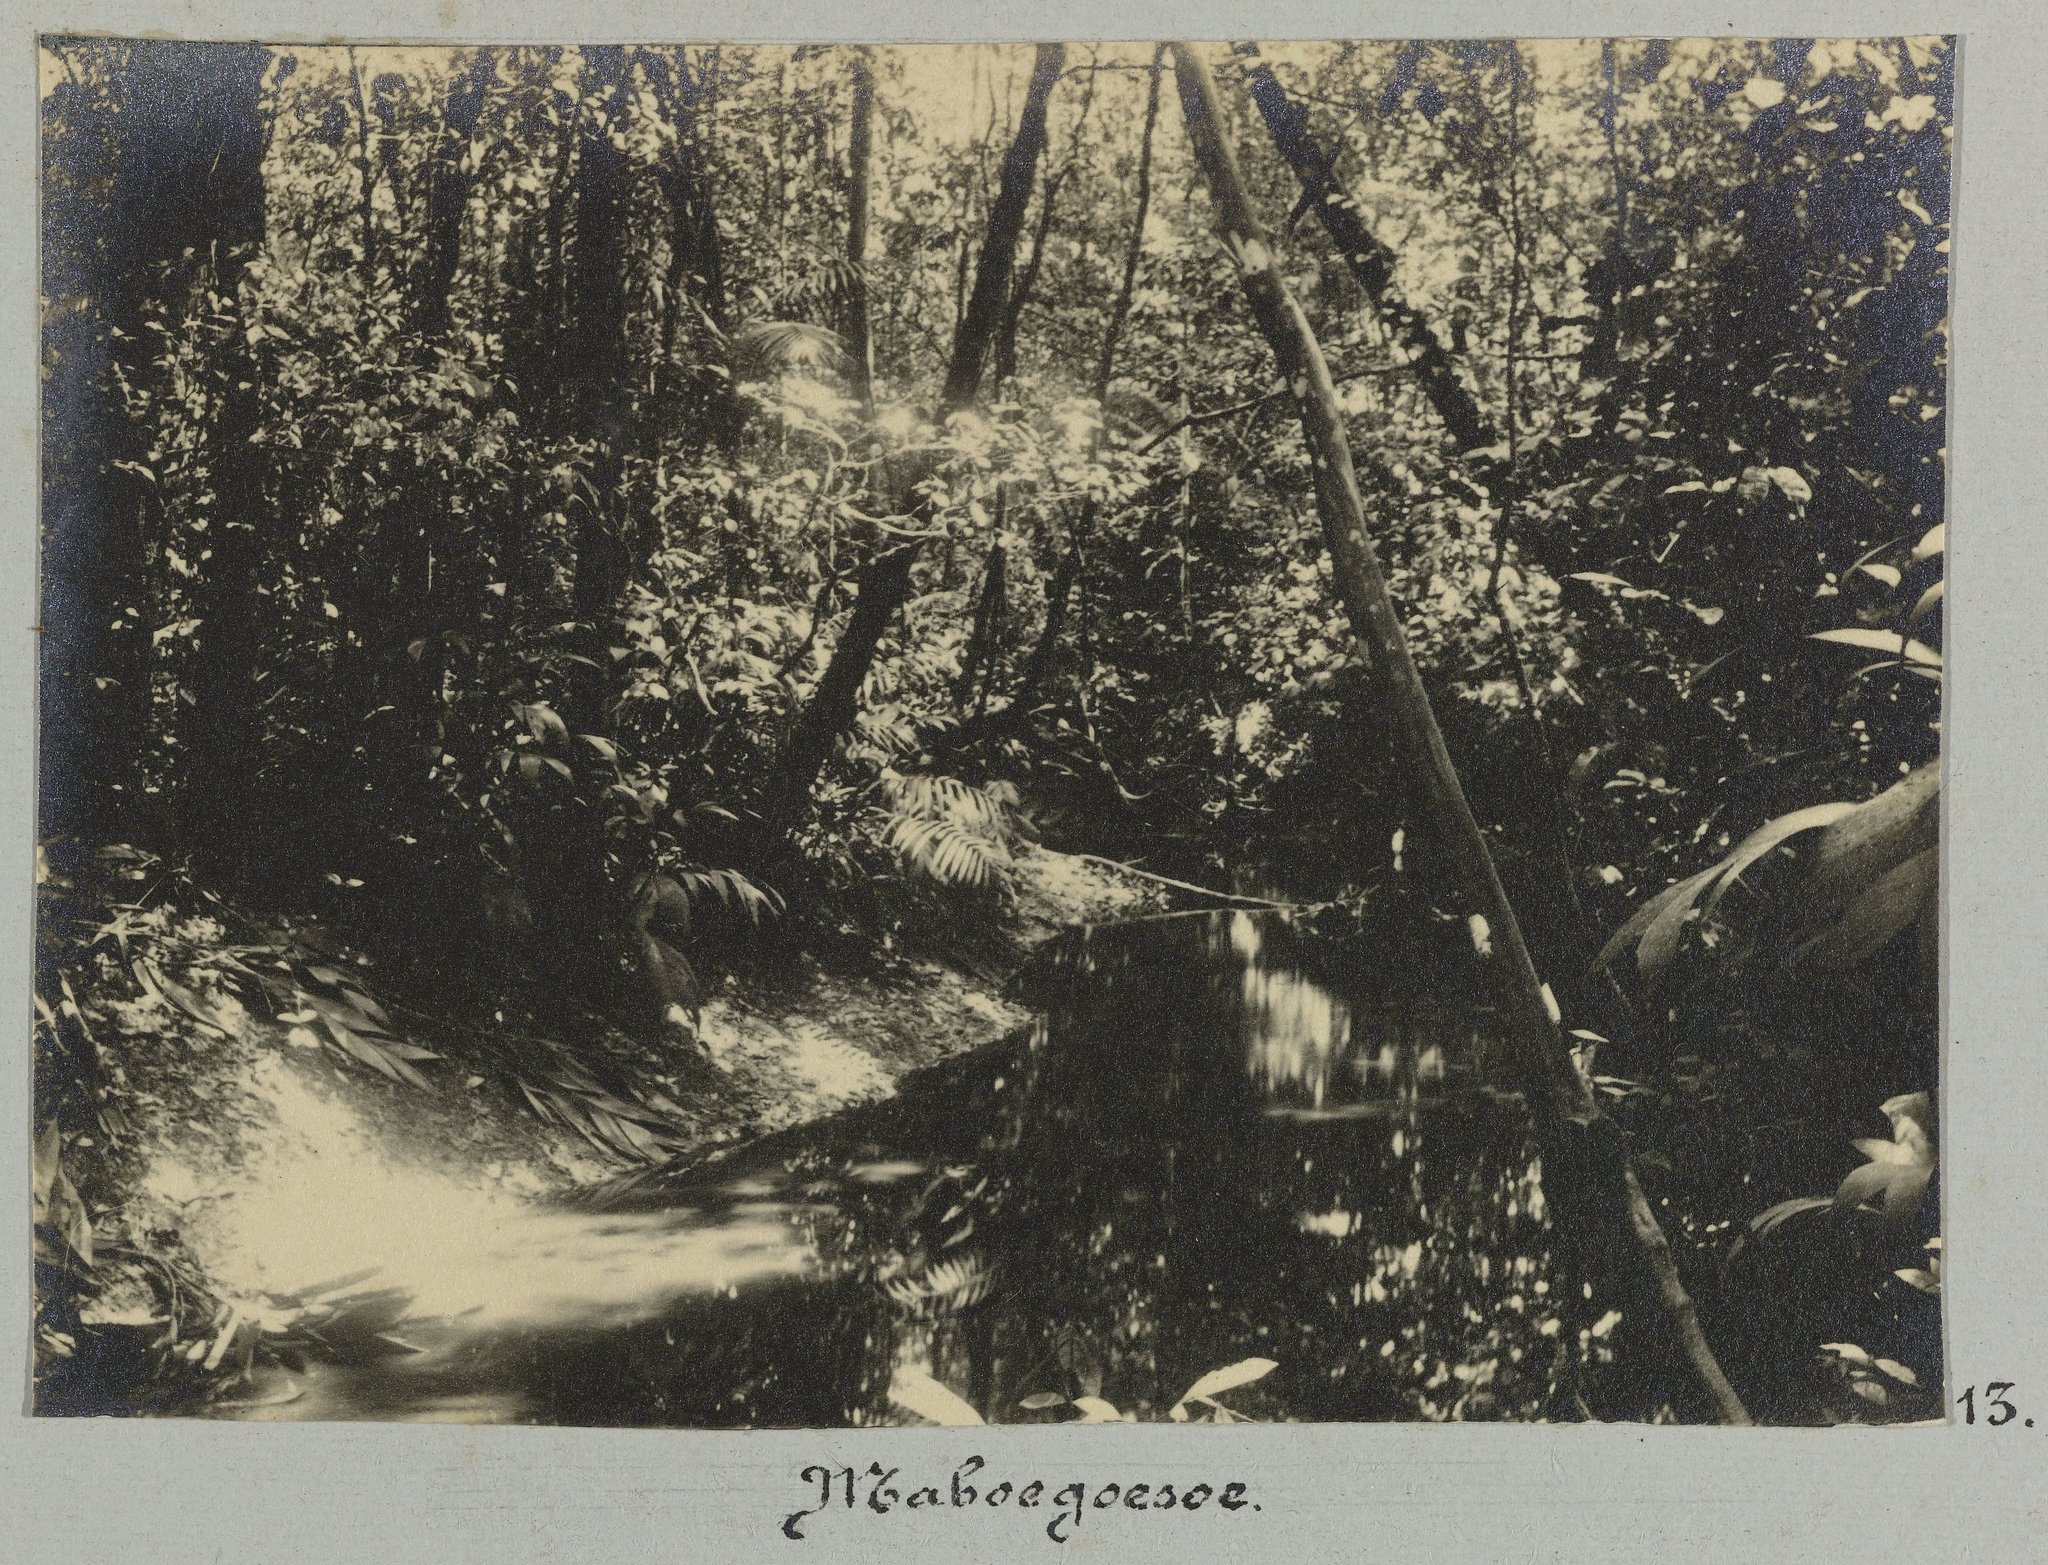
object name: photograph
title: Maboegoesoe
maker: hendrik doijer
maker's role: engineer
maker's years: 1863-1925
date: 1903-1910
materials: photographic support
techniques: gelatin silver print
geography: suriname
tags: suriname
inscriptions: inscription: ‘13. / Maboegoesoe.’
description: Gezicht in het oerwoud bij Maboegoesoe. Onderdeel van het fotoalbum Souvenir de Voyage (deel 1), over het leven van de familie Doijer in en rond de plantage Ma Retraite in Suriname in de jaren 1903-1910.